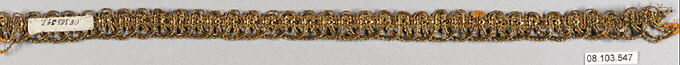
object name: galloon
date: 1701-1800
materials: metal thread